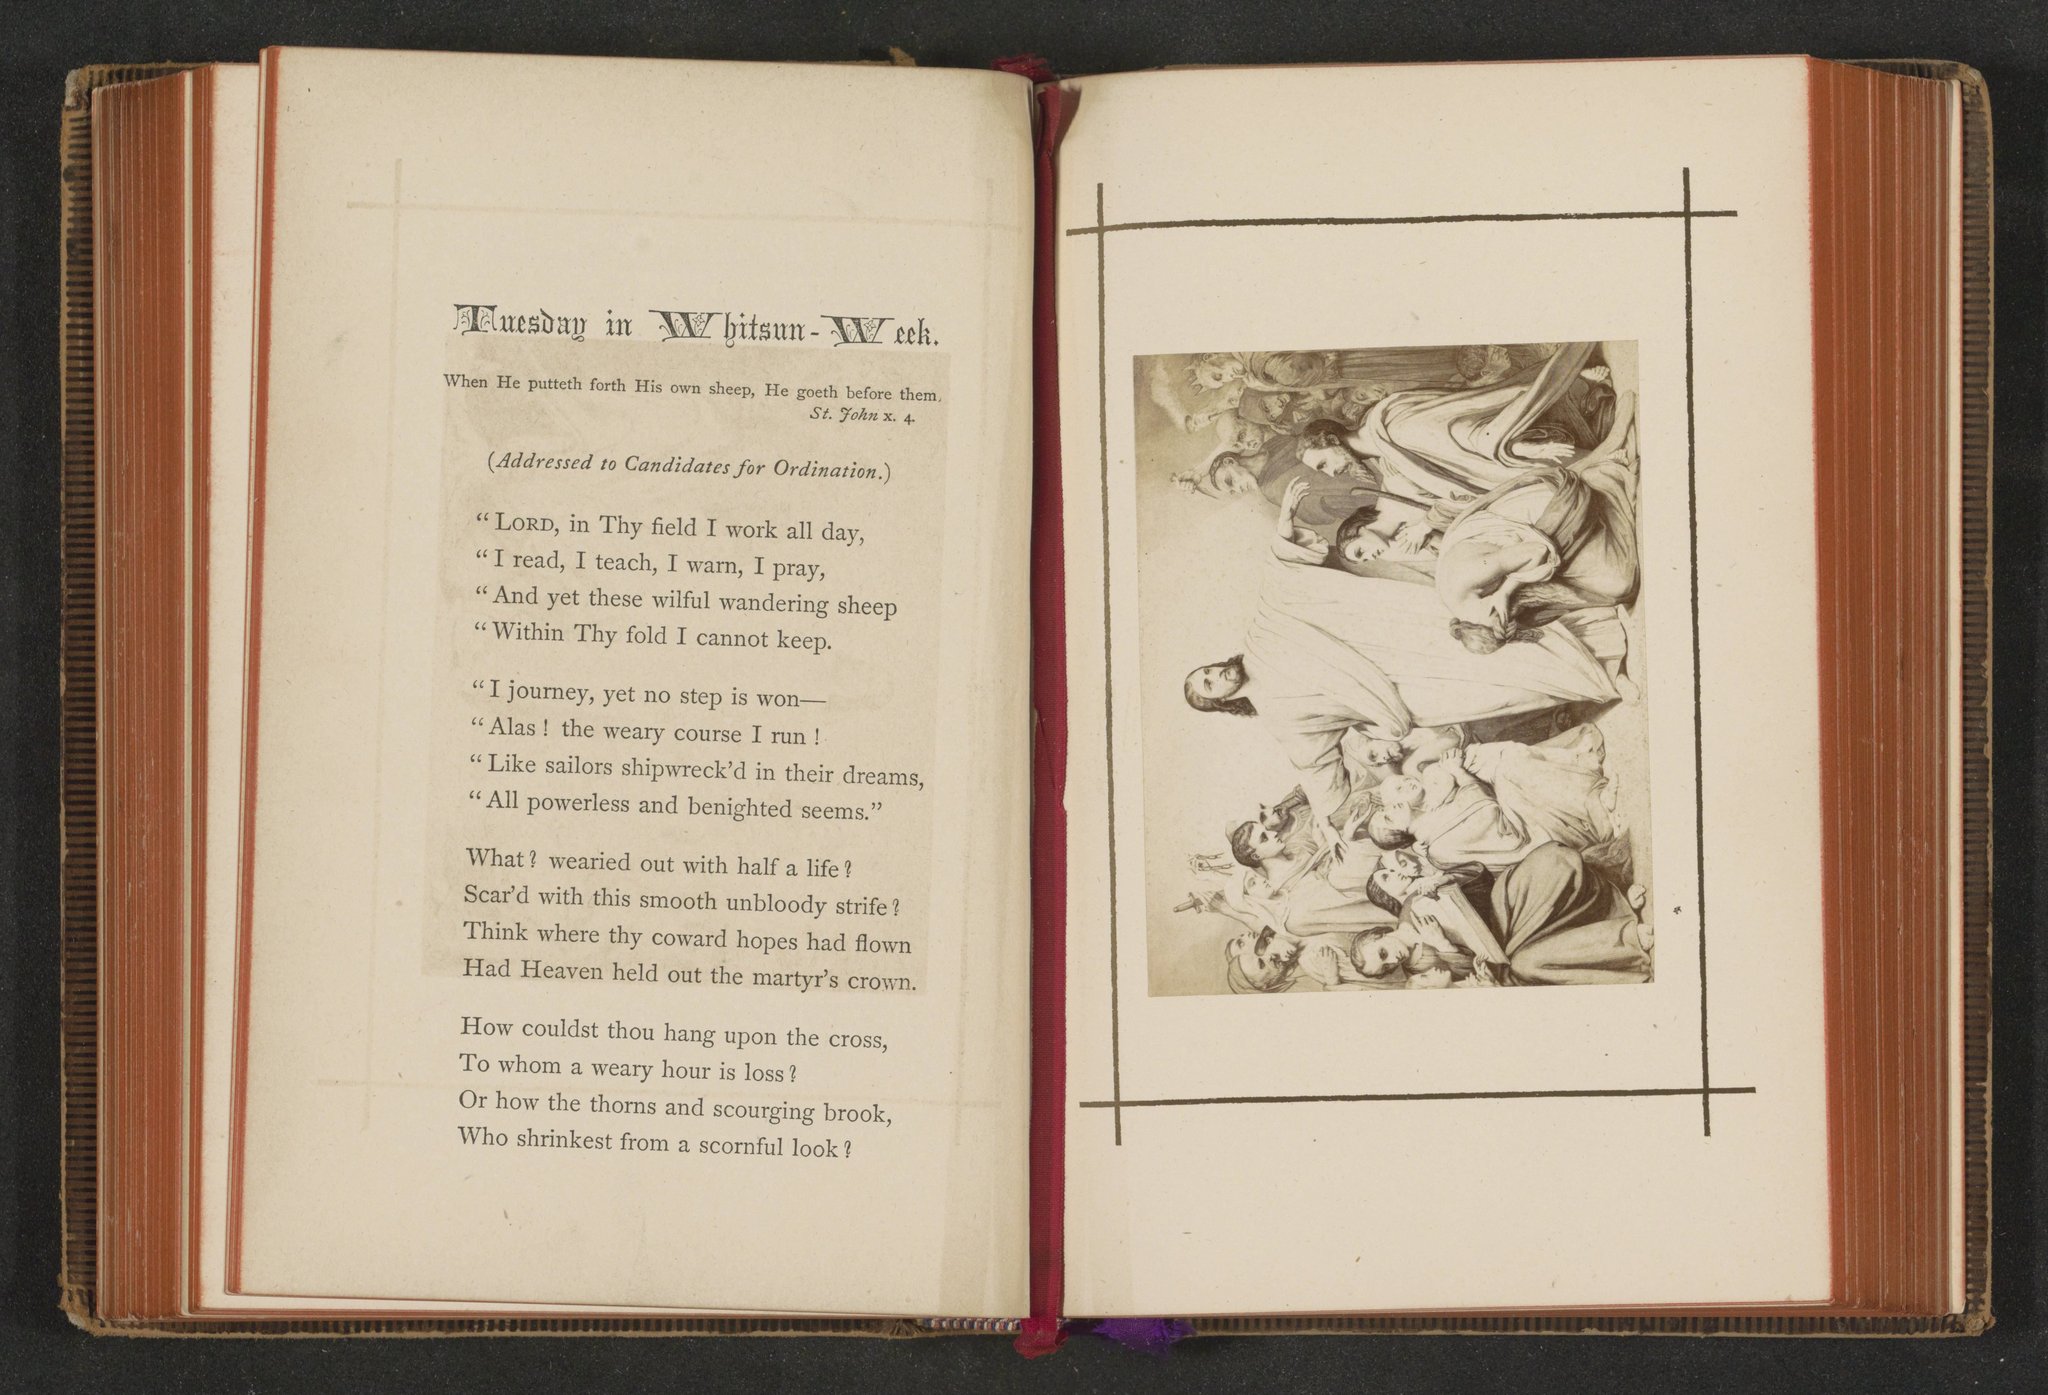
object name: photograph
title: Fotoreproductie van een prent, voorstellende Christus als goede herder met volgelingen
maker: Anonymous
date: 1865-1870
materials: photographic support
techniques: albumen print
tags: the sheep follow the good shepherd ~ parable of the good shepherd